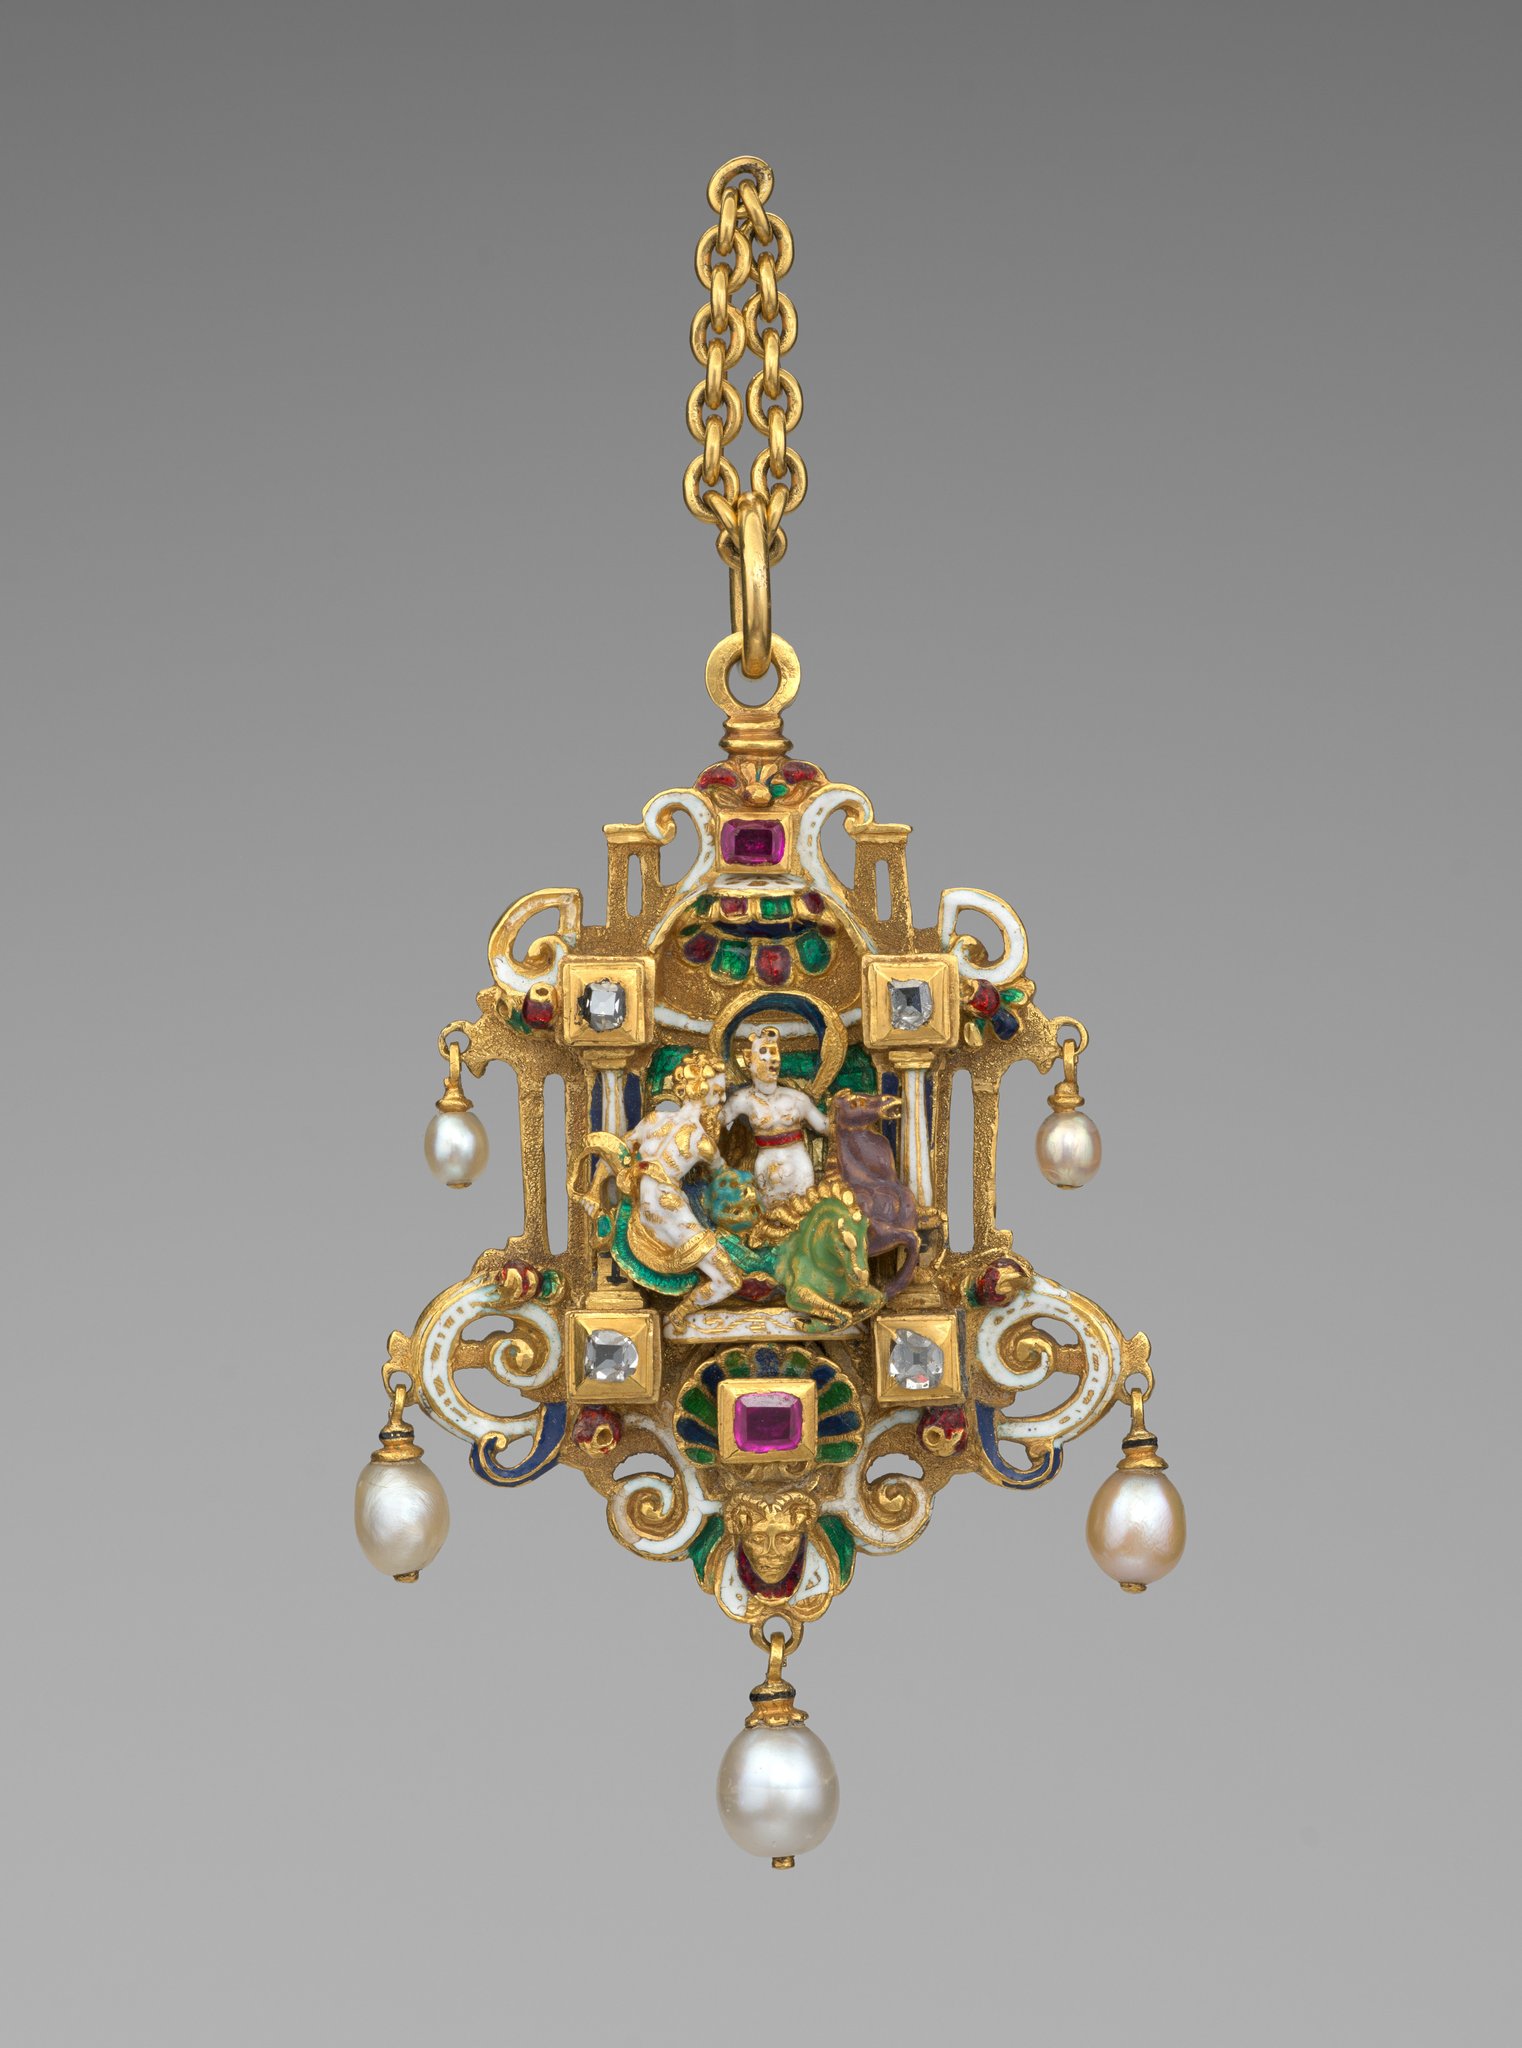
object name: pendant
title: Sixteenth-century-style pendant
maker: reinhold vasters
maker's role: designer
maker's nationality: german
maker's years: 1827-1909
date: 1801-1900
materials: diamond, enamel, gold, pearl, gemstone